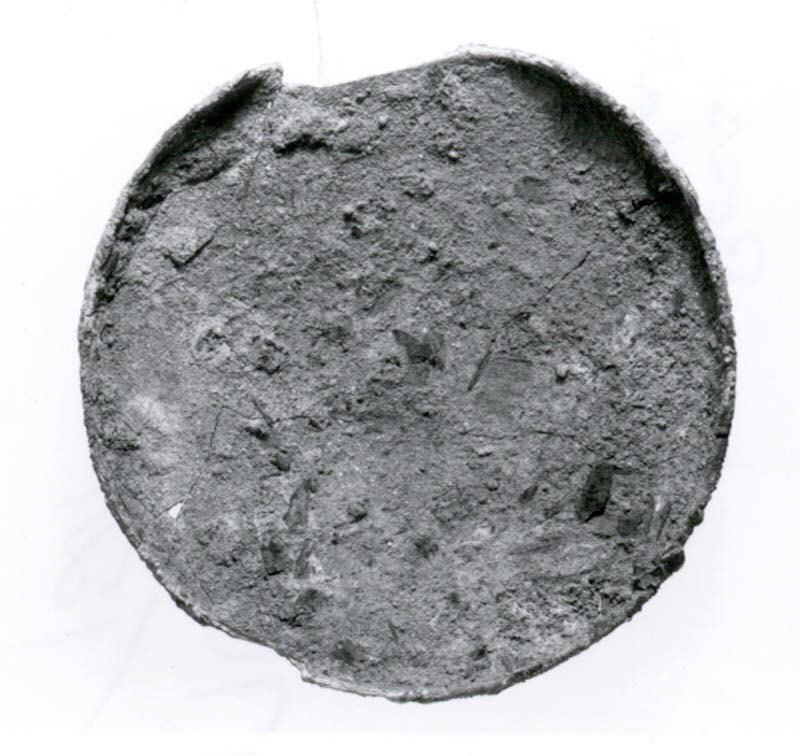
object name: dish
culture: iranian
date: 900-801 BCE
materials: bronze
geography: iran